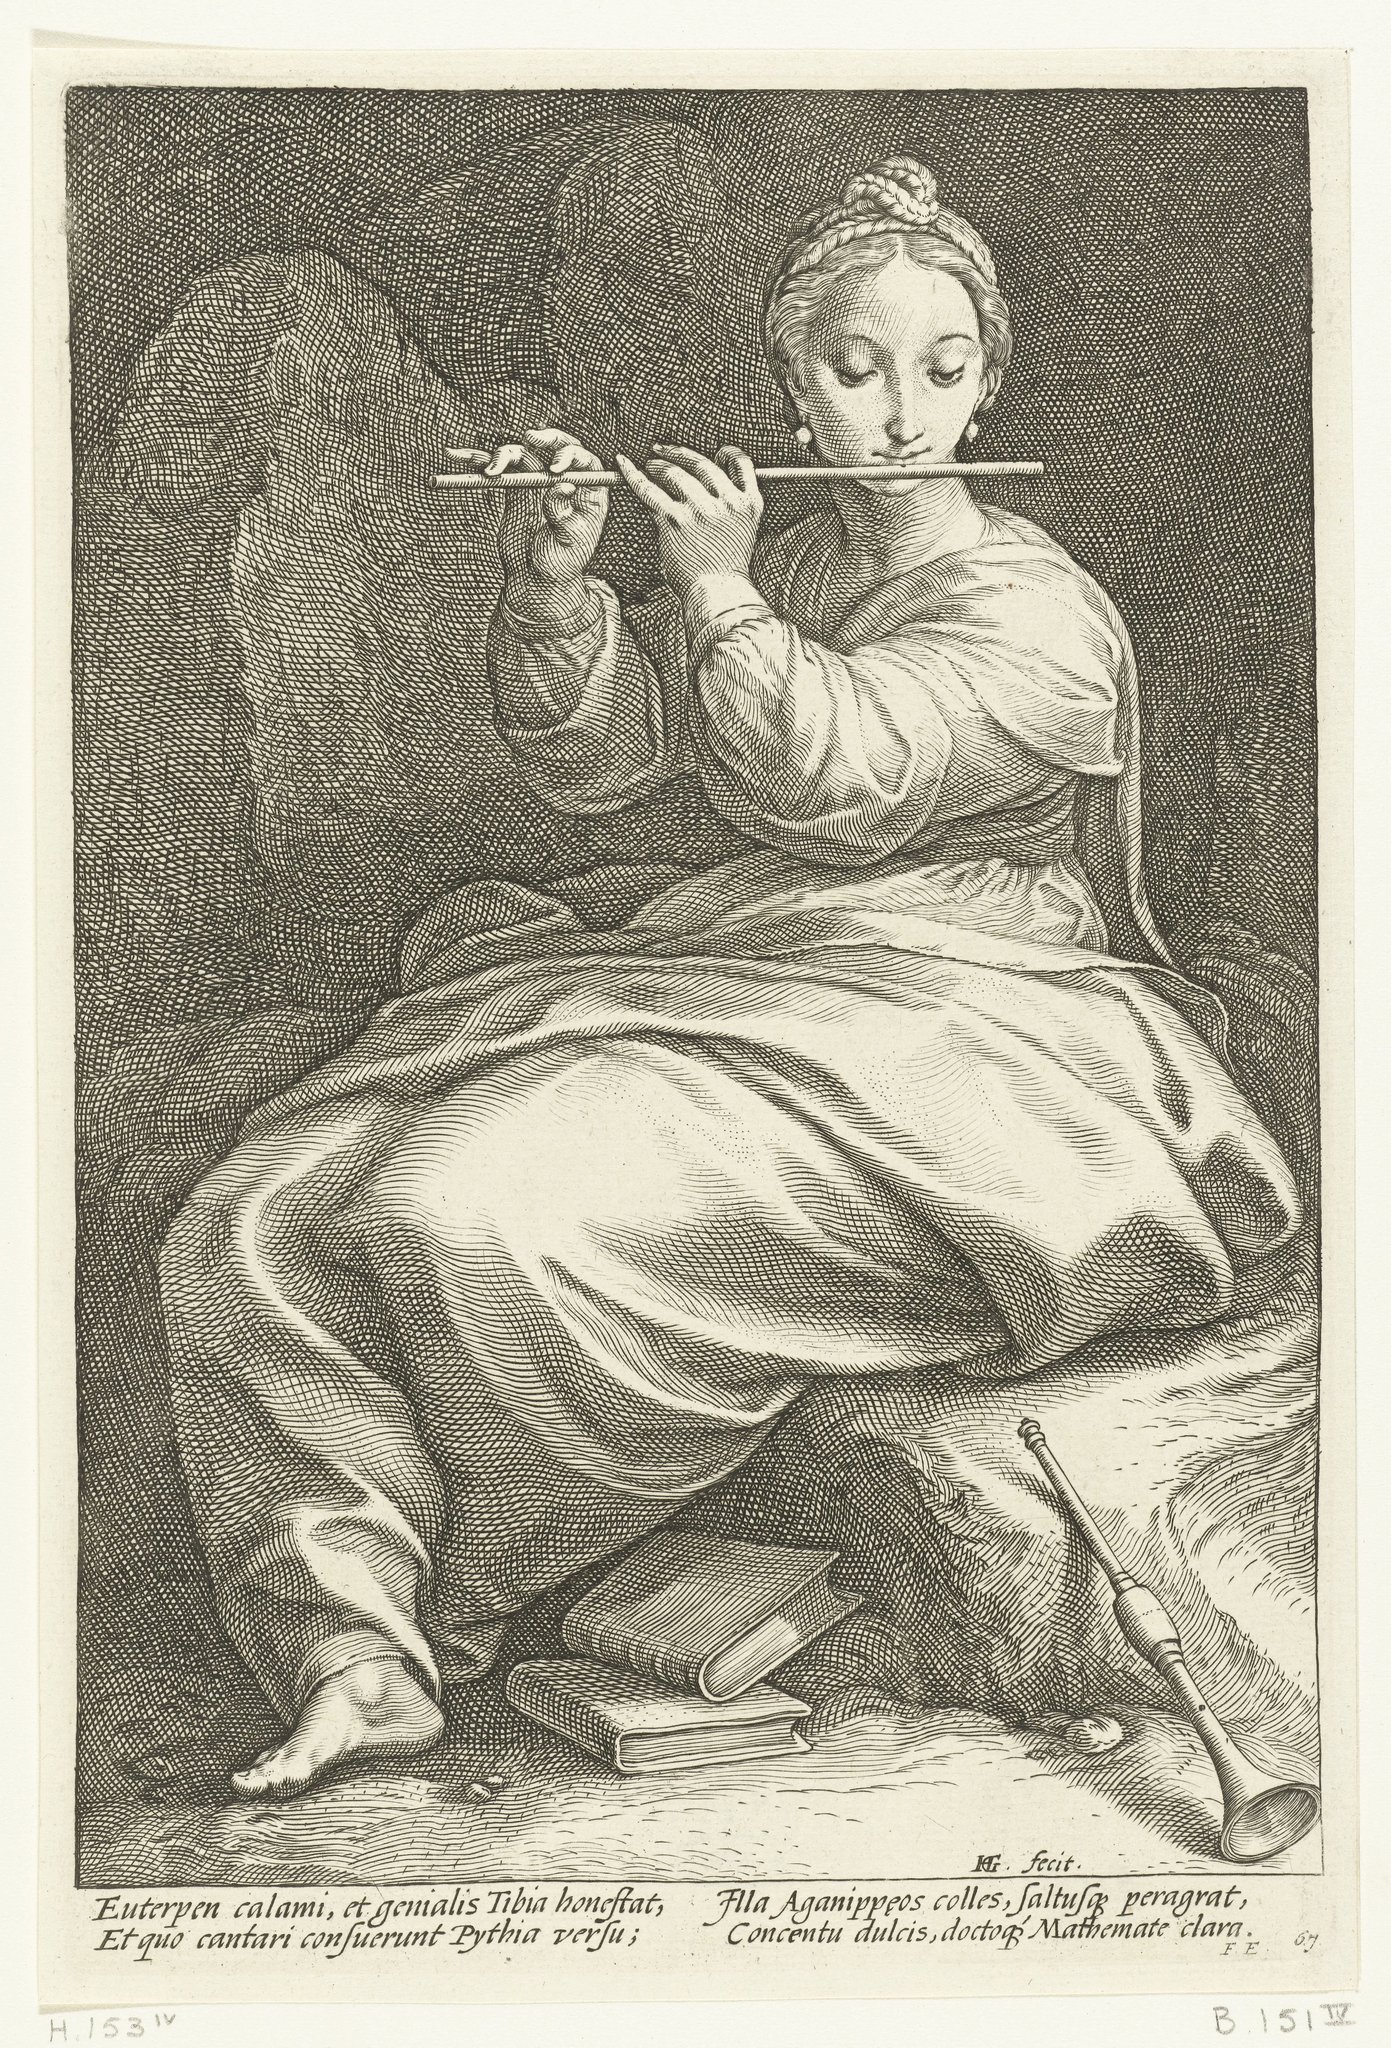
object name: print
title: Euterpe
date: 1592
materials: paper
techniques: engraving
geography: haarlem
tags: euterpe (one of the muses); 'euterpe' (ripa)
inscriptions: collector's mark: Lugt 2228a, signature: ‘HG. fecit’, signature: ‘F.E.’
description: Een serie van negen muzen. Vier regels Latijn van Franco Estius in marge onder prent.